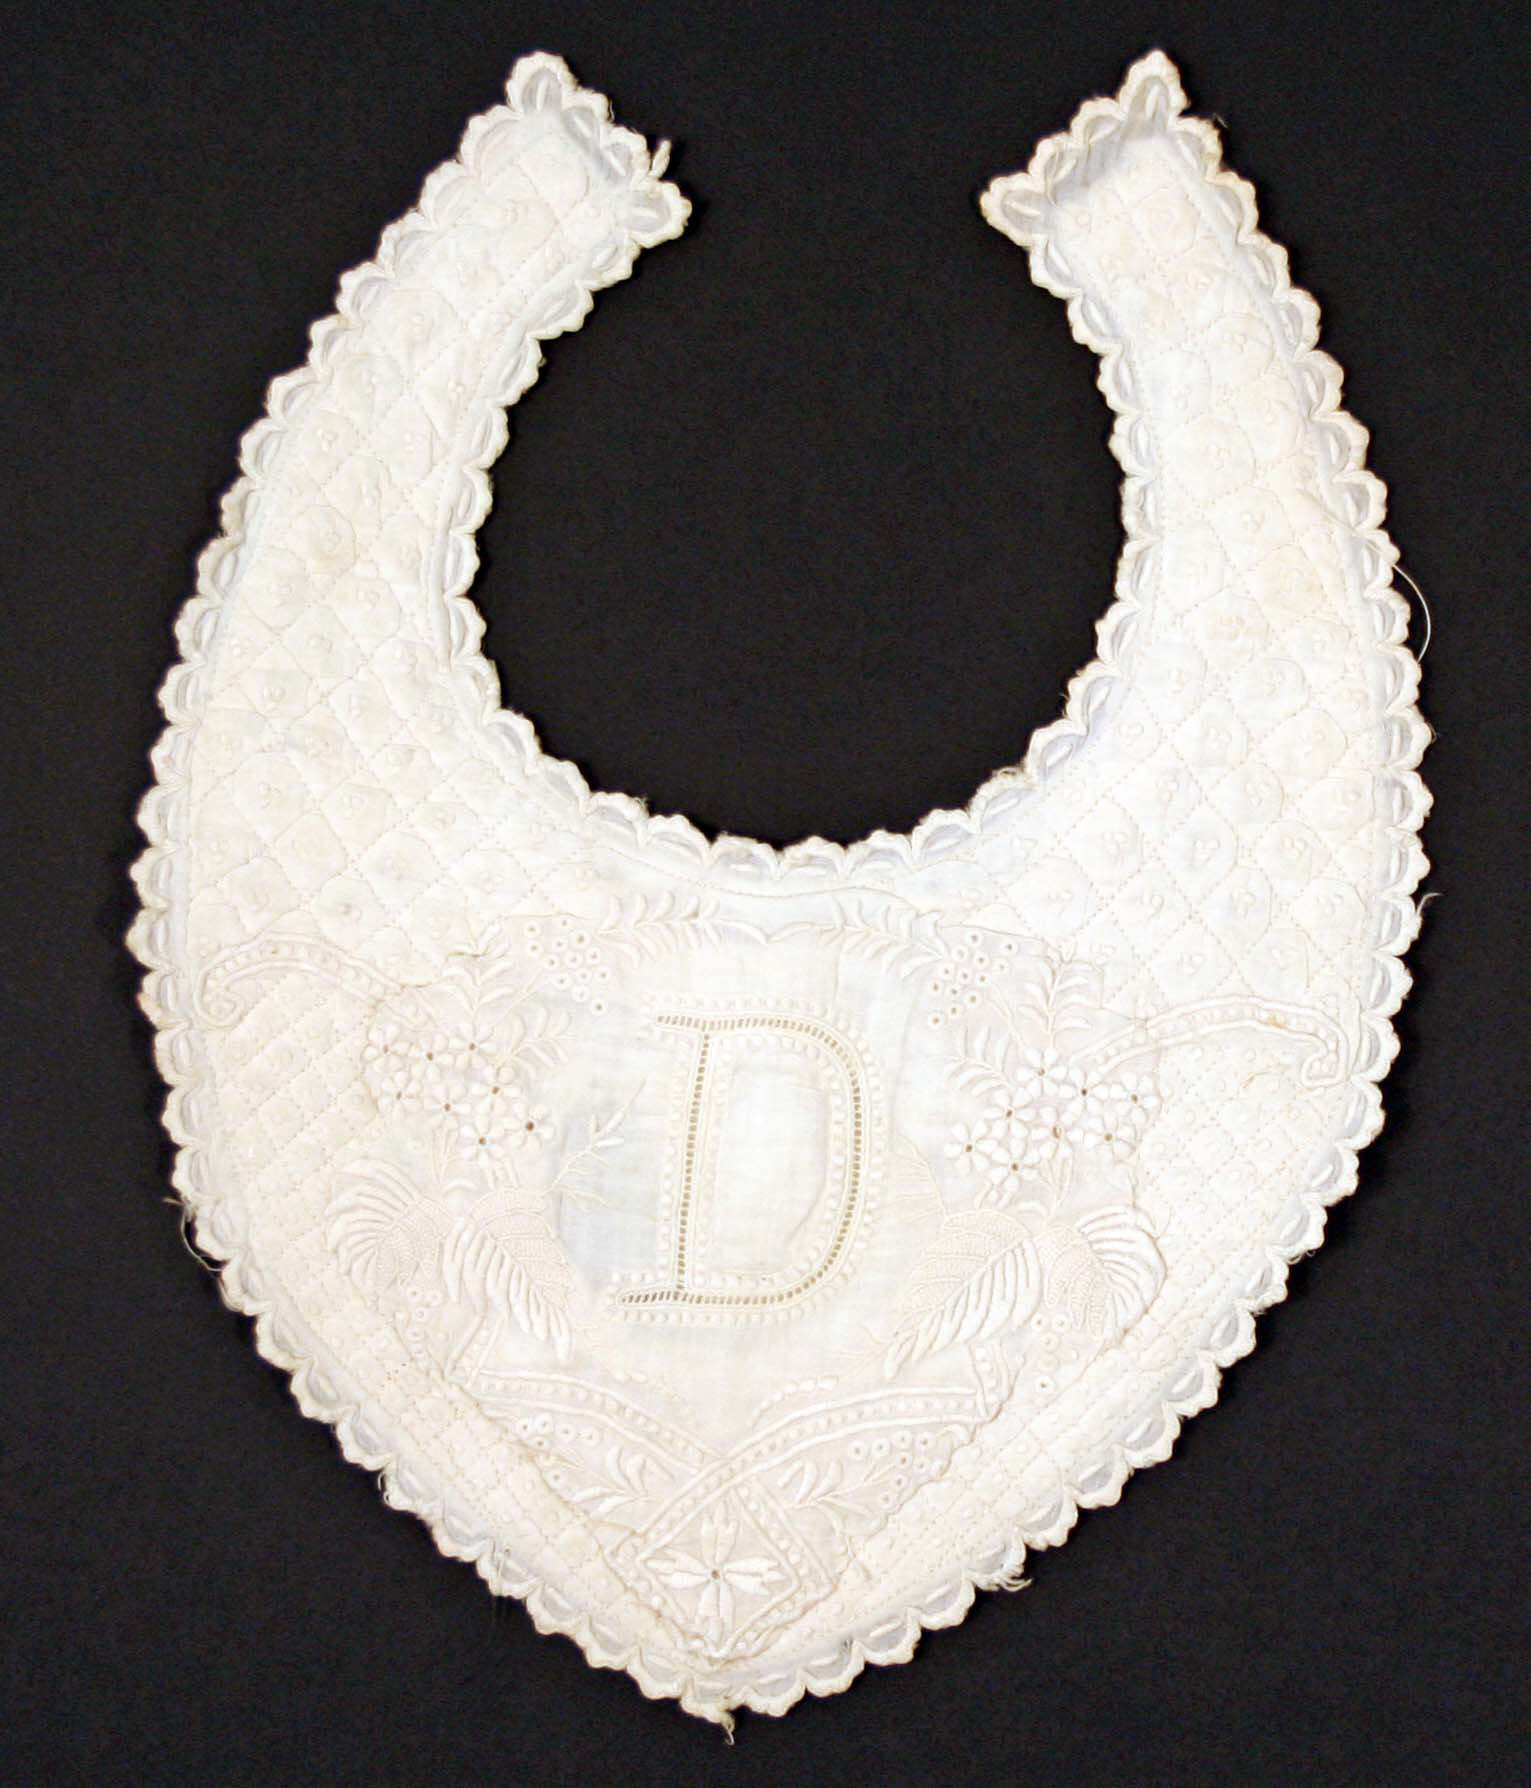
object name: bib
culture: american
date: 1876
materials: cotton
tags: flowers